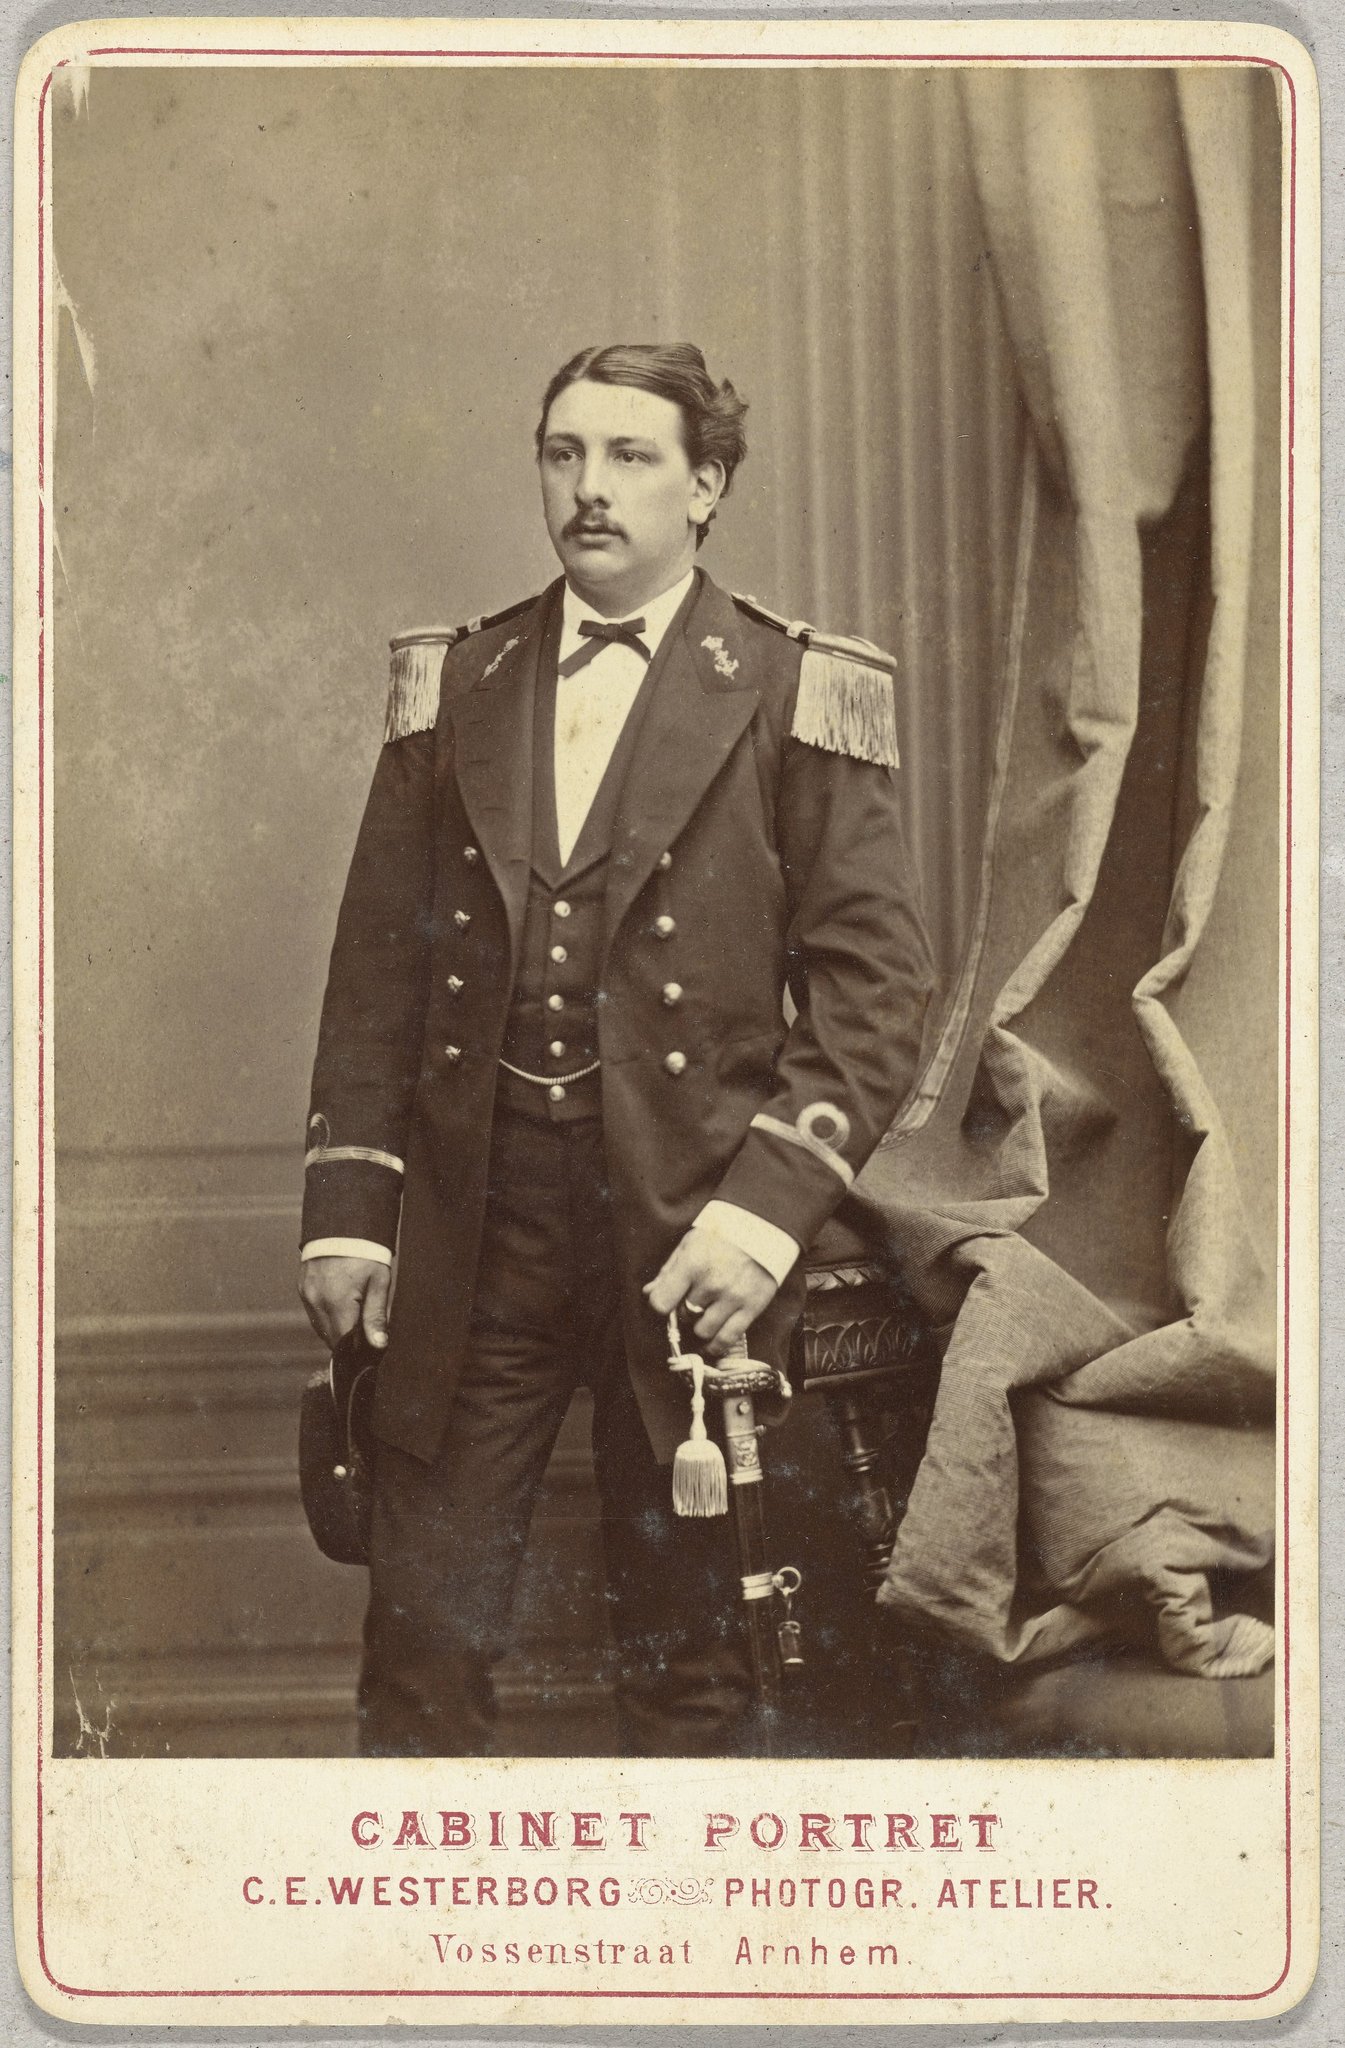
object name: photograph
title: Portret van Willem van Braam in militair kostuum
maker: carel eduard westerborg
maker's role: fotograaf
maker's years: 1842-1916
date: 1875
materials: cardboard, paper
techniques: albumen print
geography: arnhem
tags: arnhem, manufacturer, willem hendrik van braam, historical persons, (military) uniforms, netherlands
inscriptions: signature: ‘Cabinet portret C.E. Westerborg phogr. Atelier Vossensingel Arnhem’